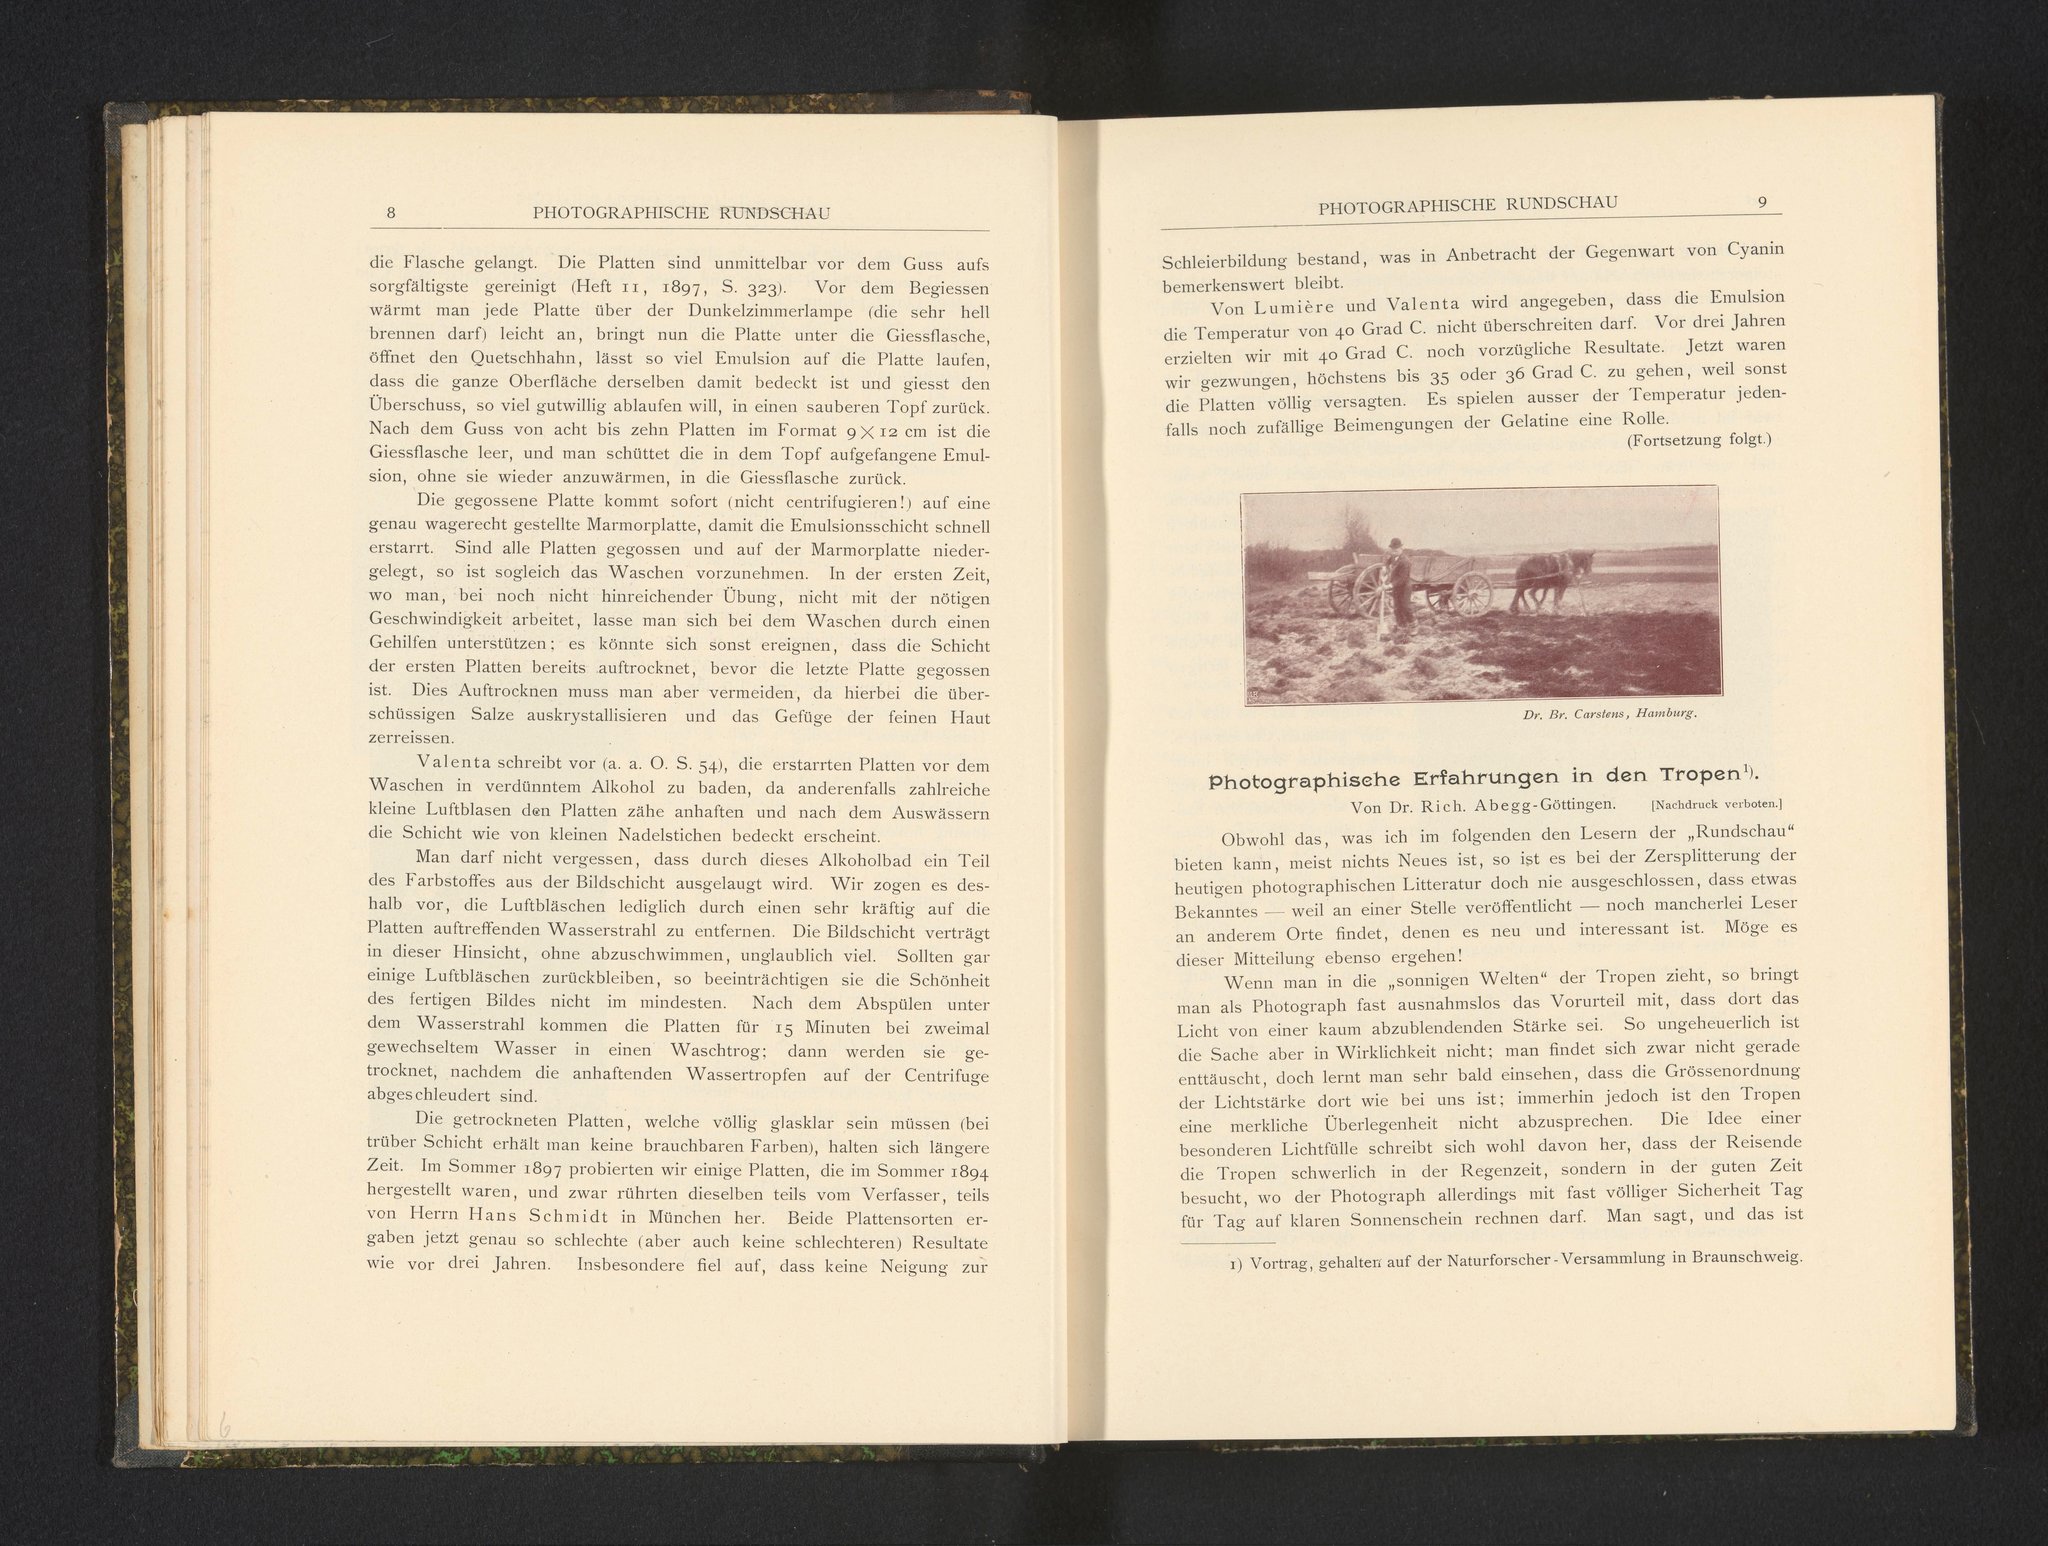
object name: photomechanical print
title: Man voor een paardenkar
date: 1893-1898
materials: paper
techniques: autotype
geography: hamburg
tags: four-wheeled, animal-drawn vehicle, e.g.: cab, carriage, coach